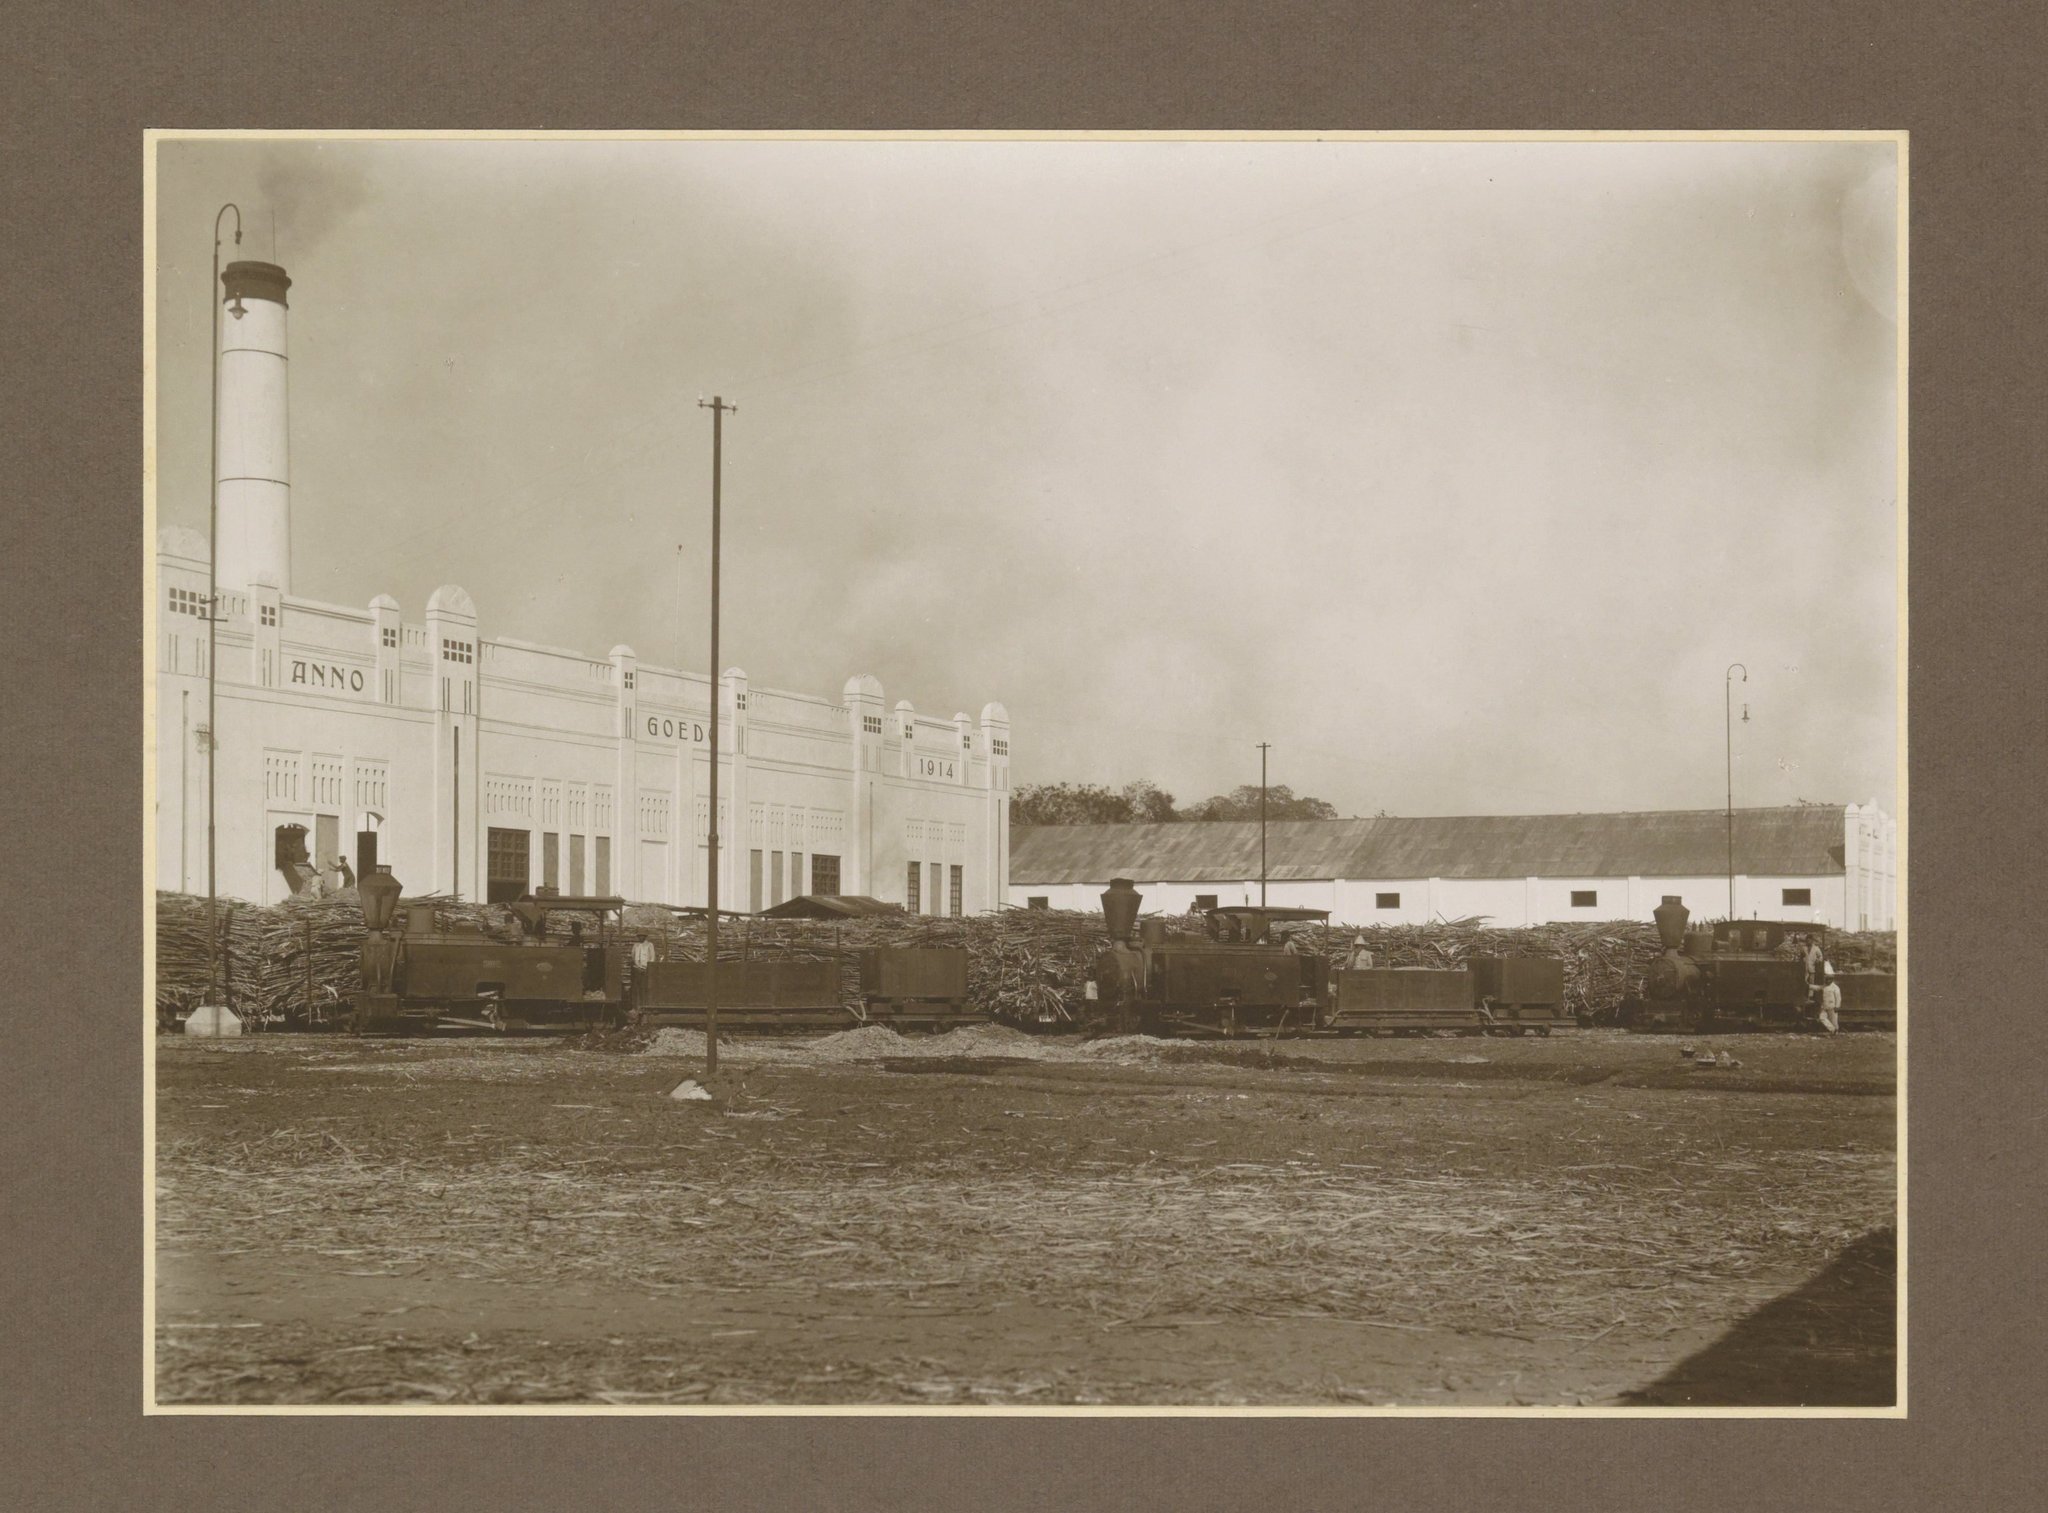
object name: album leaf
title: Emplacement met treinwagons en hal met schoorsteen van suikerfabriek Goedo te Djombang op Java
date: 1925-1930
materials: cardboard, paper, photographic support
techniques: gelatin silver print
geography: jombang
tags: plantation, smoke-stack, factory-building, platform (railway, tramway) (+ propulsion of vehicle, ship, etc. by ...), railway, train, plants and herbs: sugarcane, sugar, dutch east indies, the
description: Onderdeel van Fotoalbum met opnames van vier suikerfabrieken op Java.